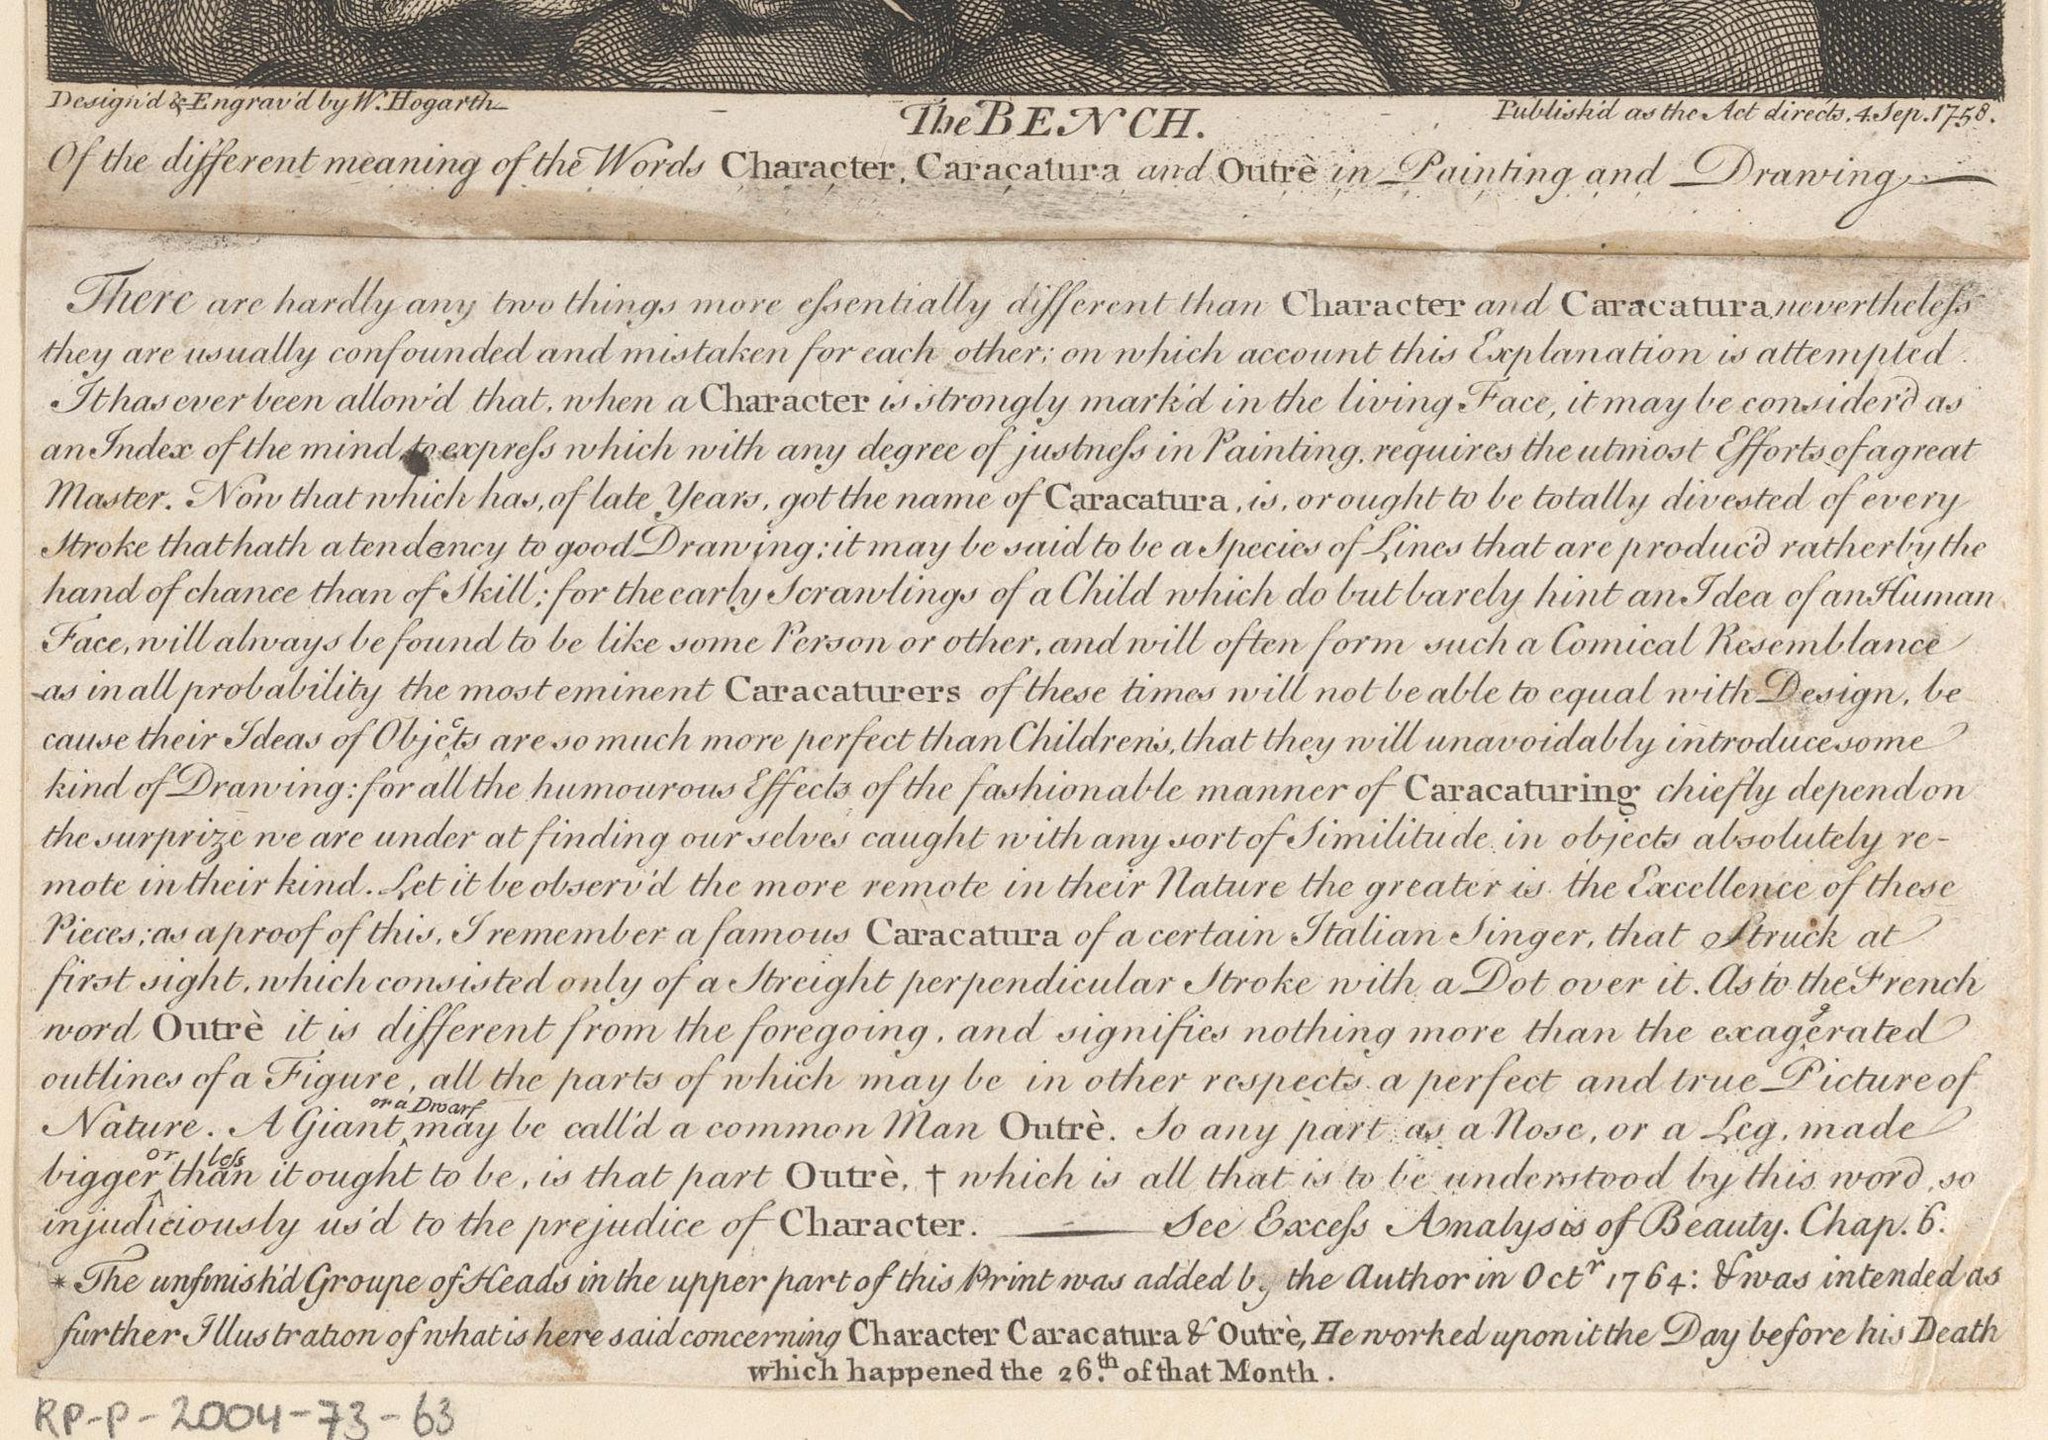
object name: cartoon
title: The Bench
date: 1758-1764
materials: paper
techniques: etching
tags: magistracy, judges, political caricatures and satires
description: De centrale rechter is waarschijnlijk John Willes en de slapende collega naast hem is mogelijk Henry Bathurst. De andere twee juryleden zijn mogelijk William Noel en Edward Clive. Boven de rechters zijn verschillende karikaturen weergegeven. Tekst in het Engels in de ondermarge. Prent maakt deel uit van een album.